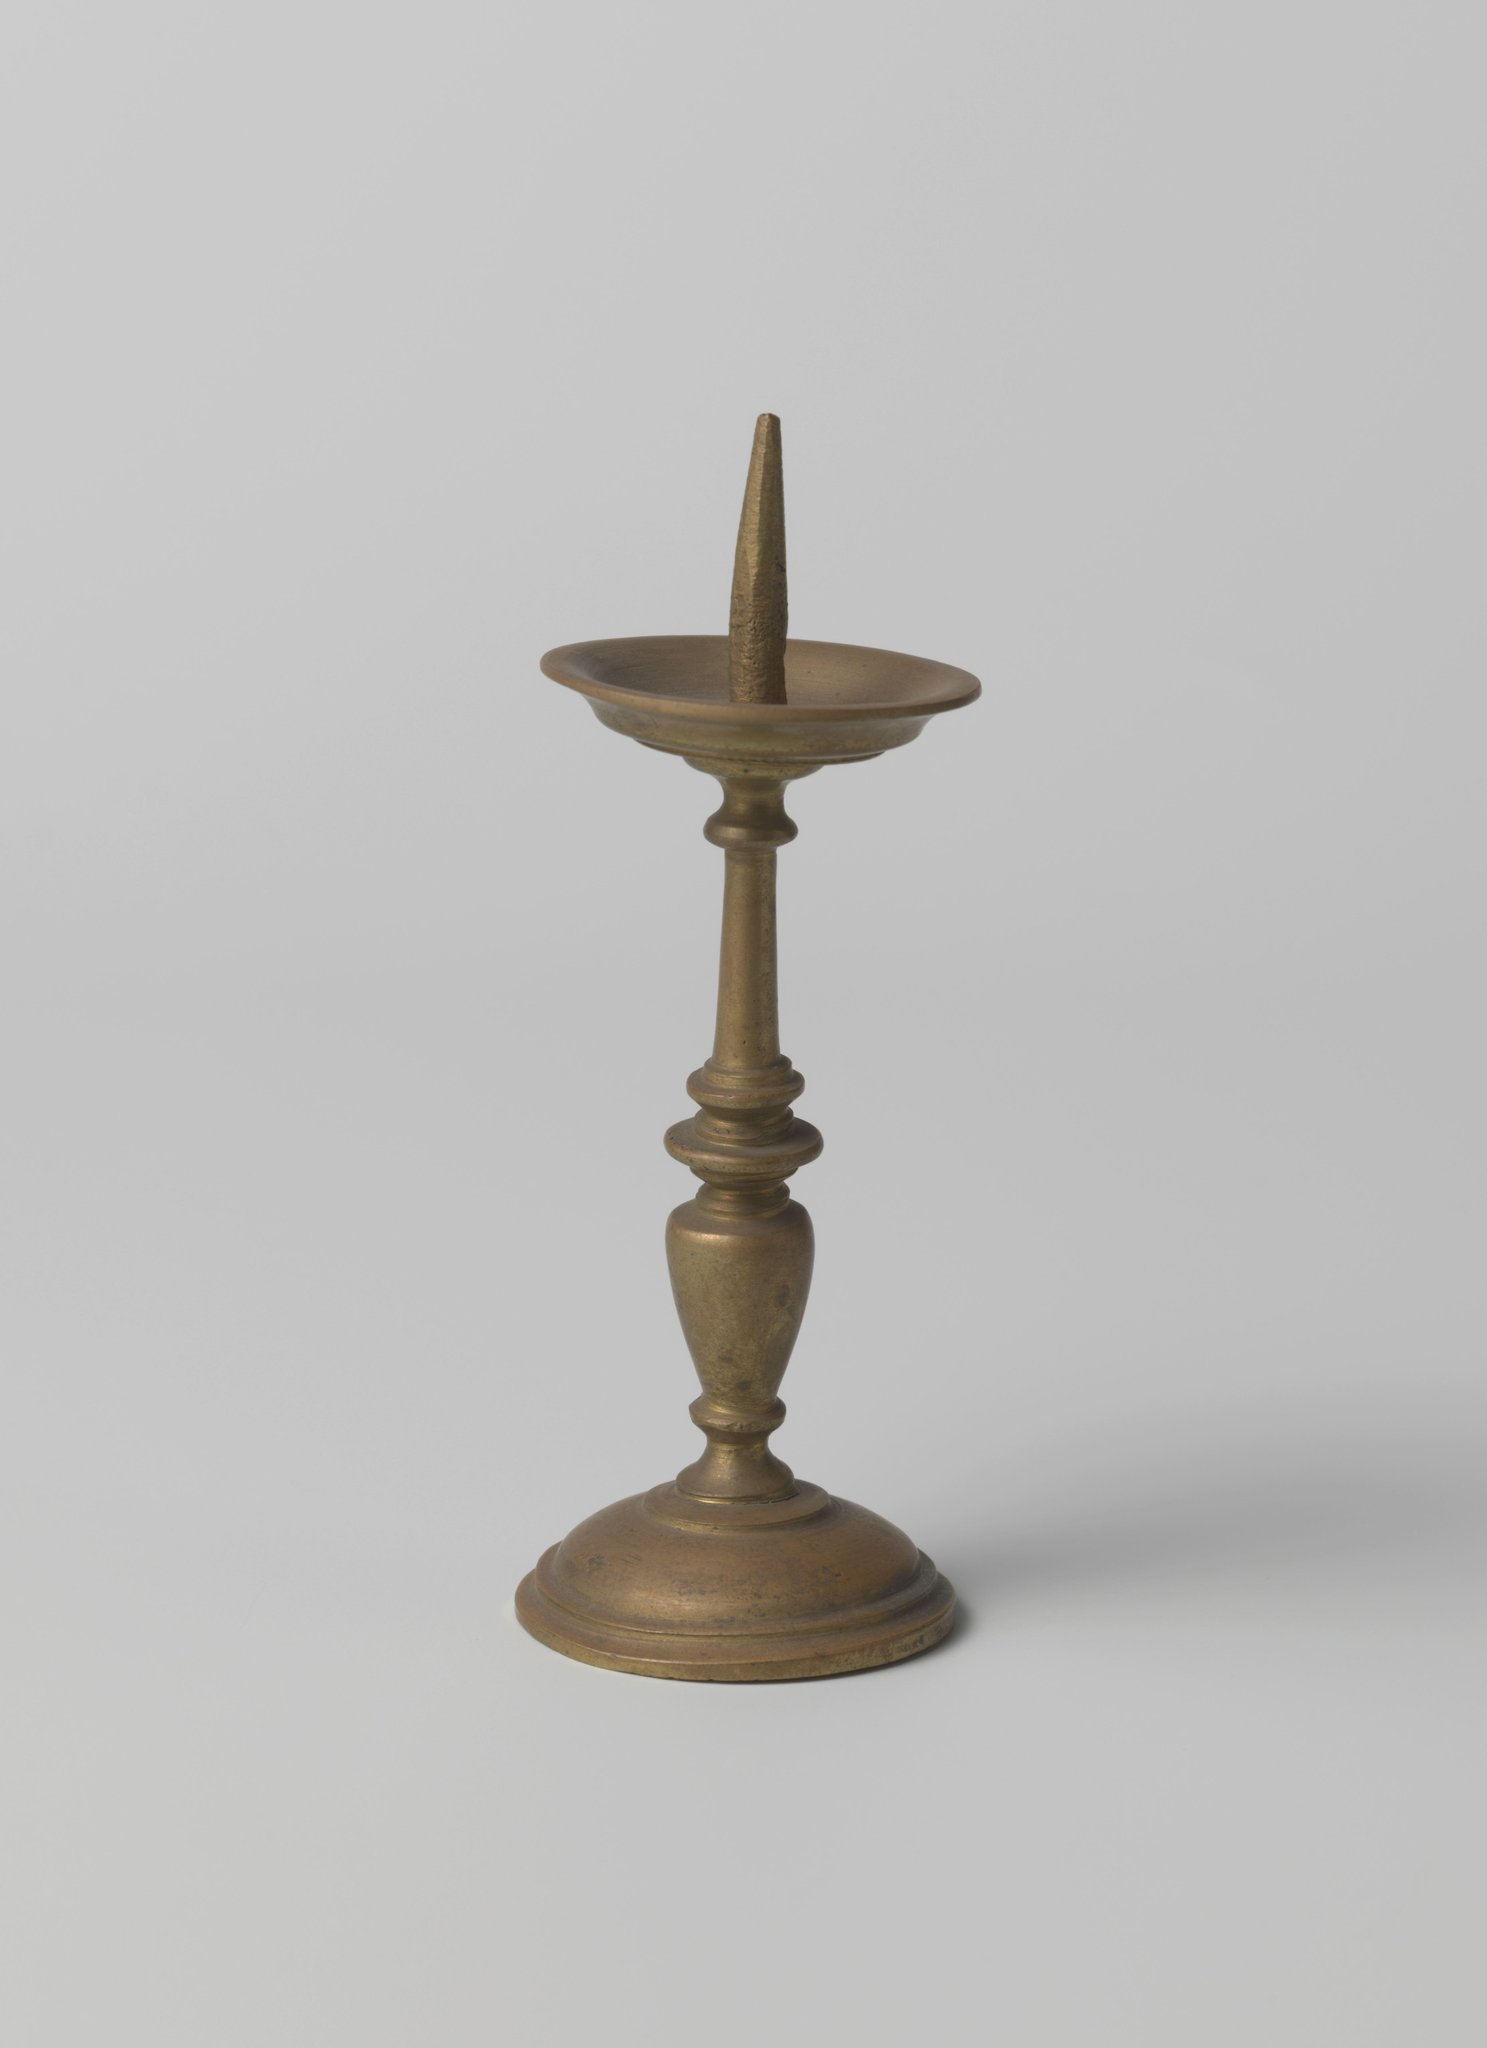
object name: candlestick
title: Kandelaar met vaasvormige stam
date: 1800-1900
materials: brass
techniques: casting, riveted, turning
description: De kandelaar is samengesteld uit vier delen: voet, stam, vetvanger en kaarsenpin. De voet is grof geprofileerd. De stam is onderaan vaasvormig. De stam is in de voet geklonken.